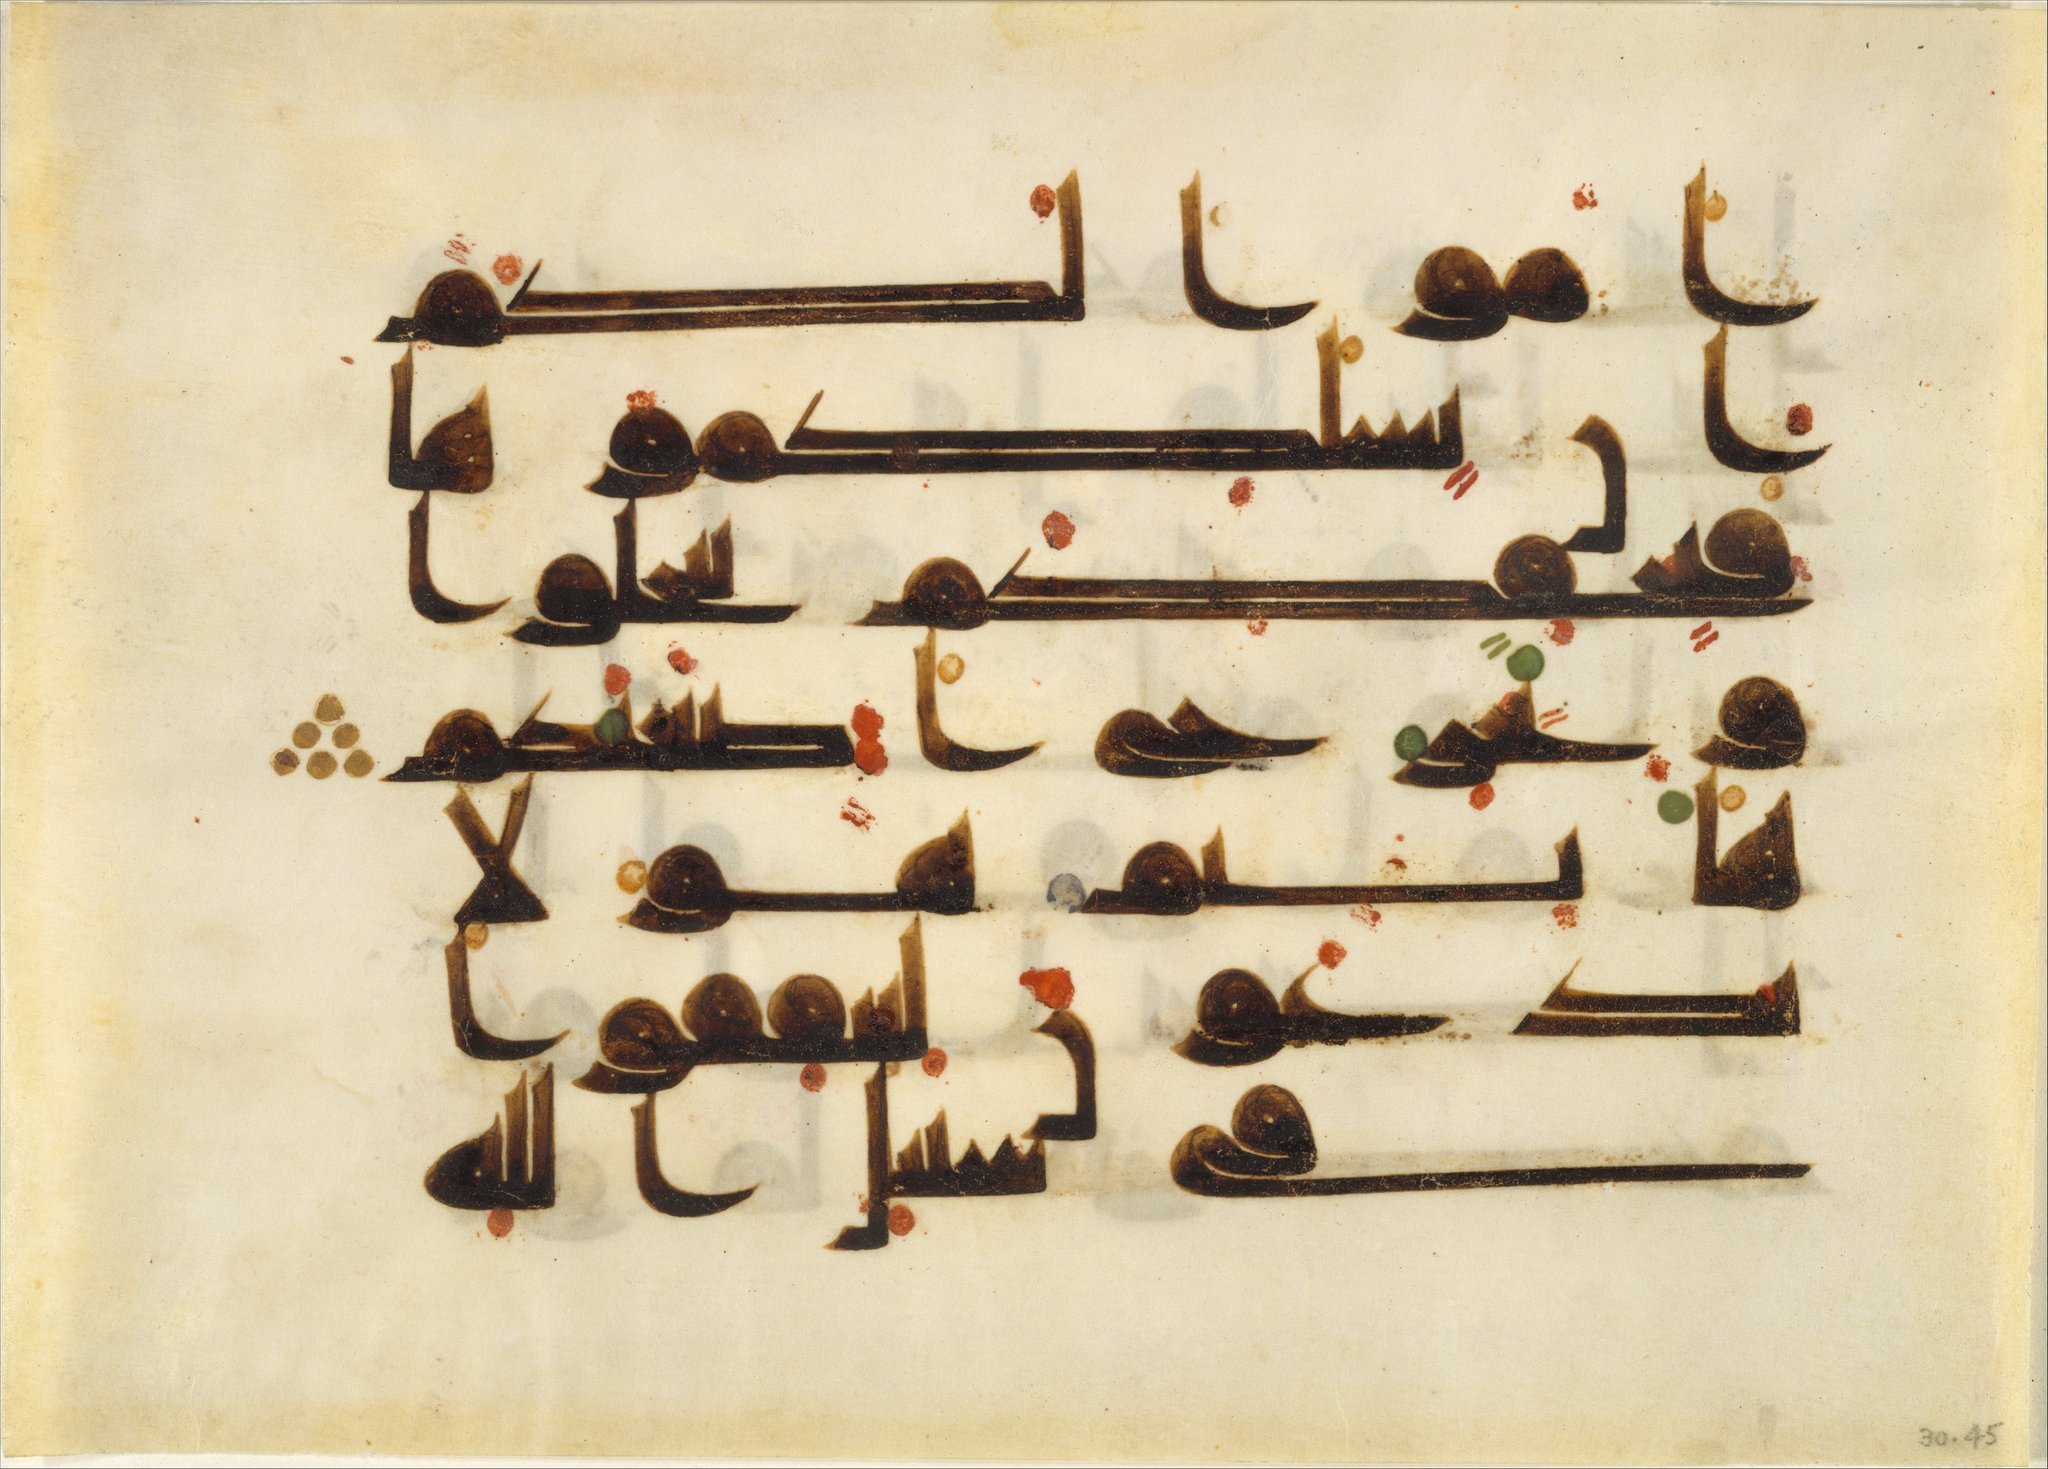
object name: folio from a non illustrated manuscript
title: Folio from a Qur'an Manuscript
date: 867-933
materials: gold, ink, parchment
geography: syria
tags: qur'an